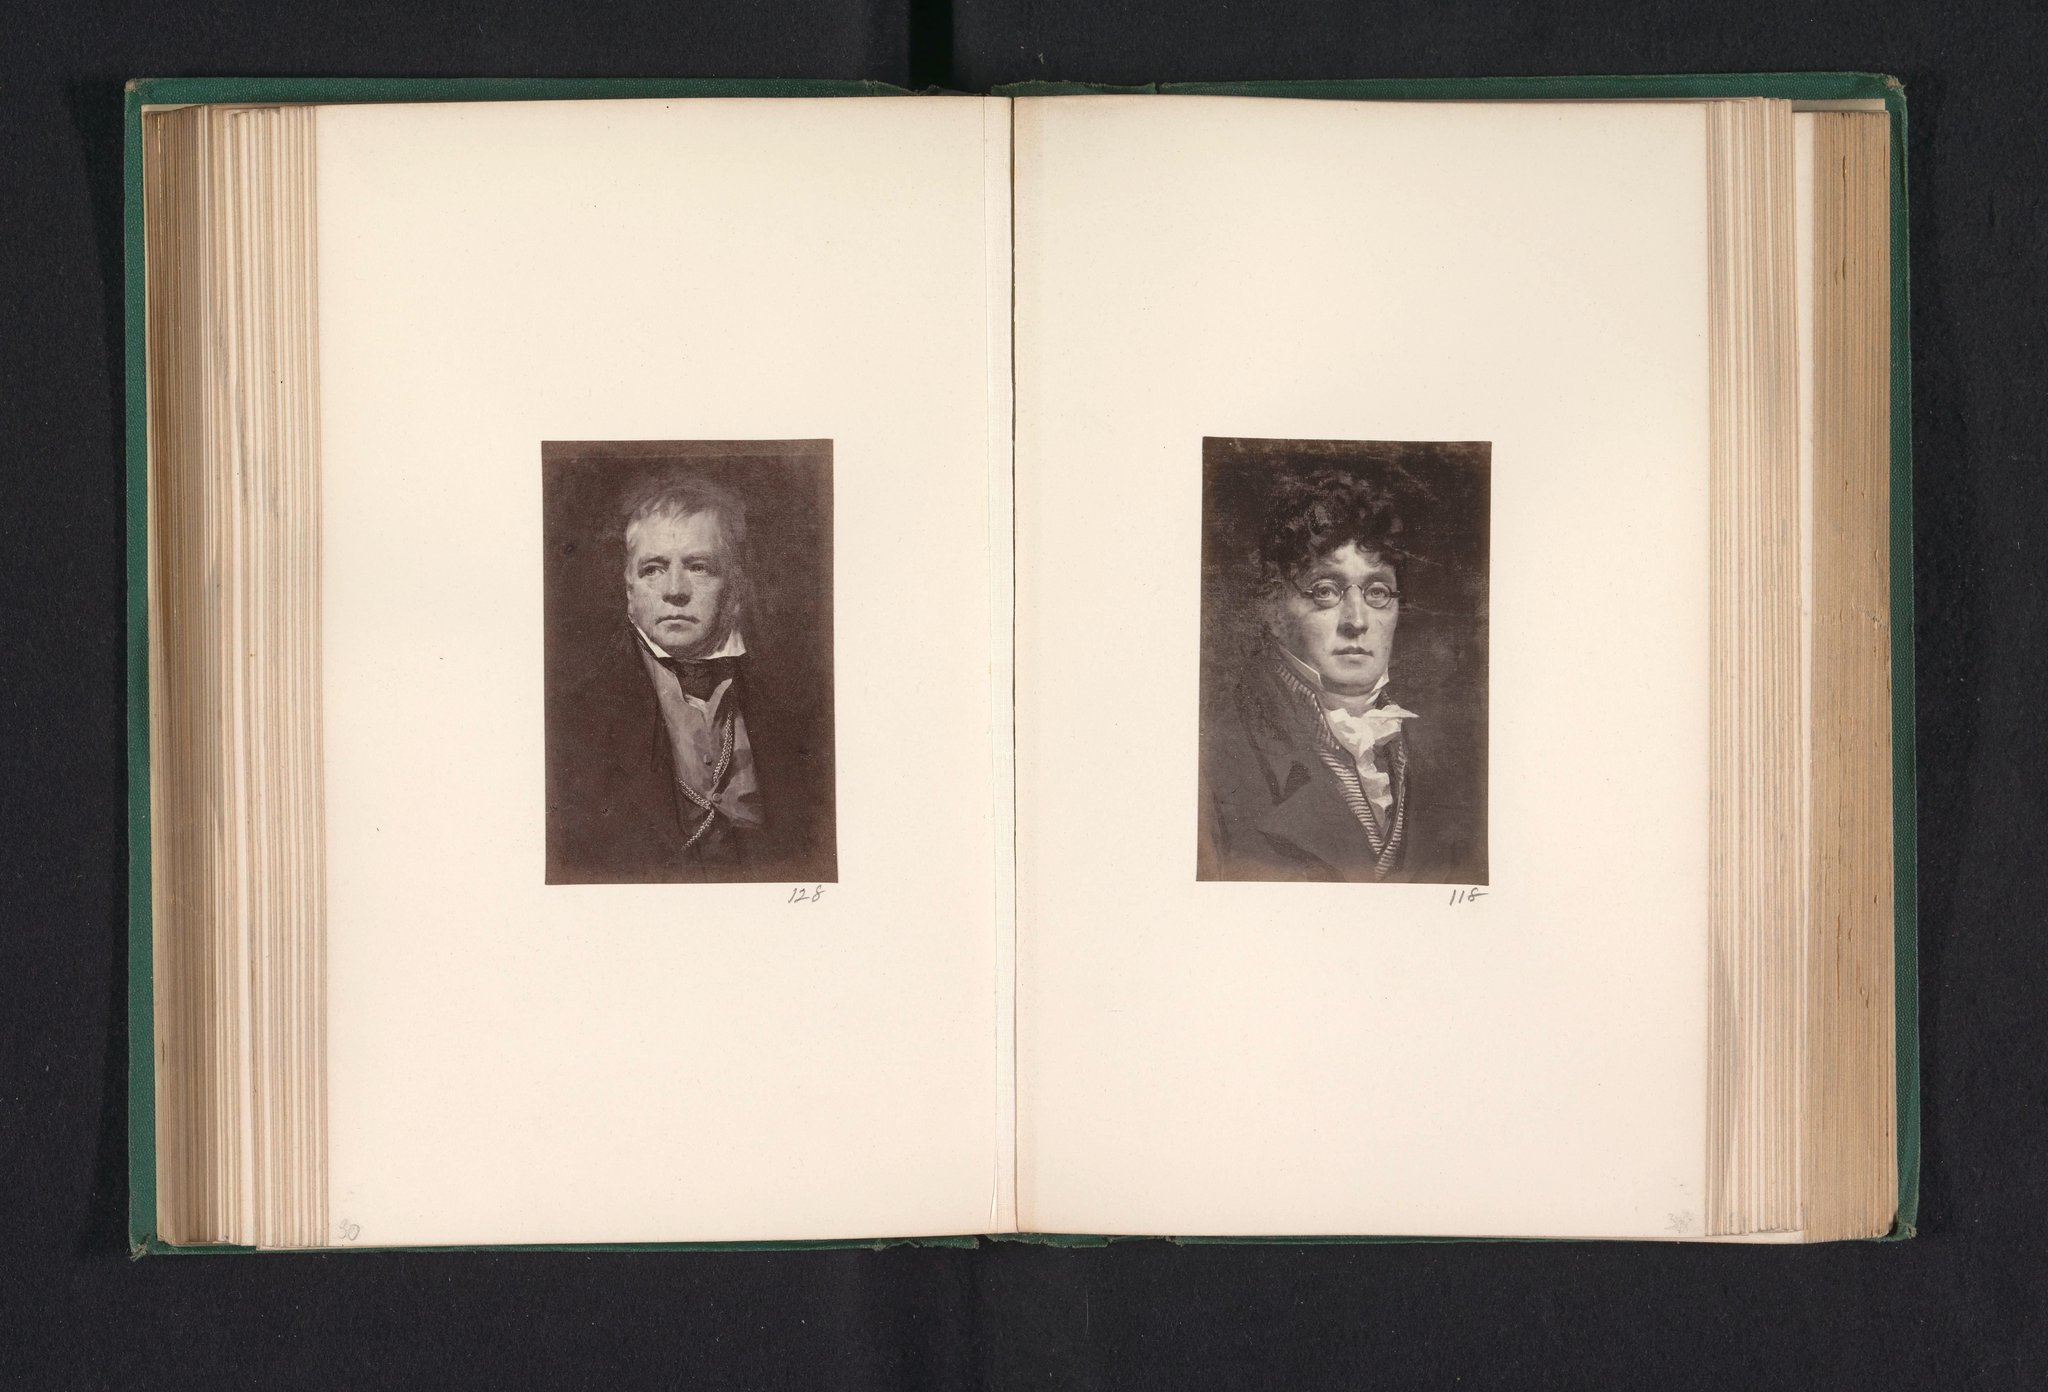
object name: photograph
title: Fotoreproductie van een schilderij, voorstellende een portret van Walter Scott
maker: thomas annan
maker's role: fotograaf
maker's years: 1829-1887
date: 1863-1868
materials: photographic support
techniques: albumen print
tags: walter scott, portrait of a writer, historical persons (portraits and scenes from the life) (+ (full) bust portrait)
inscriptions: number: ‘128’